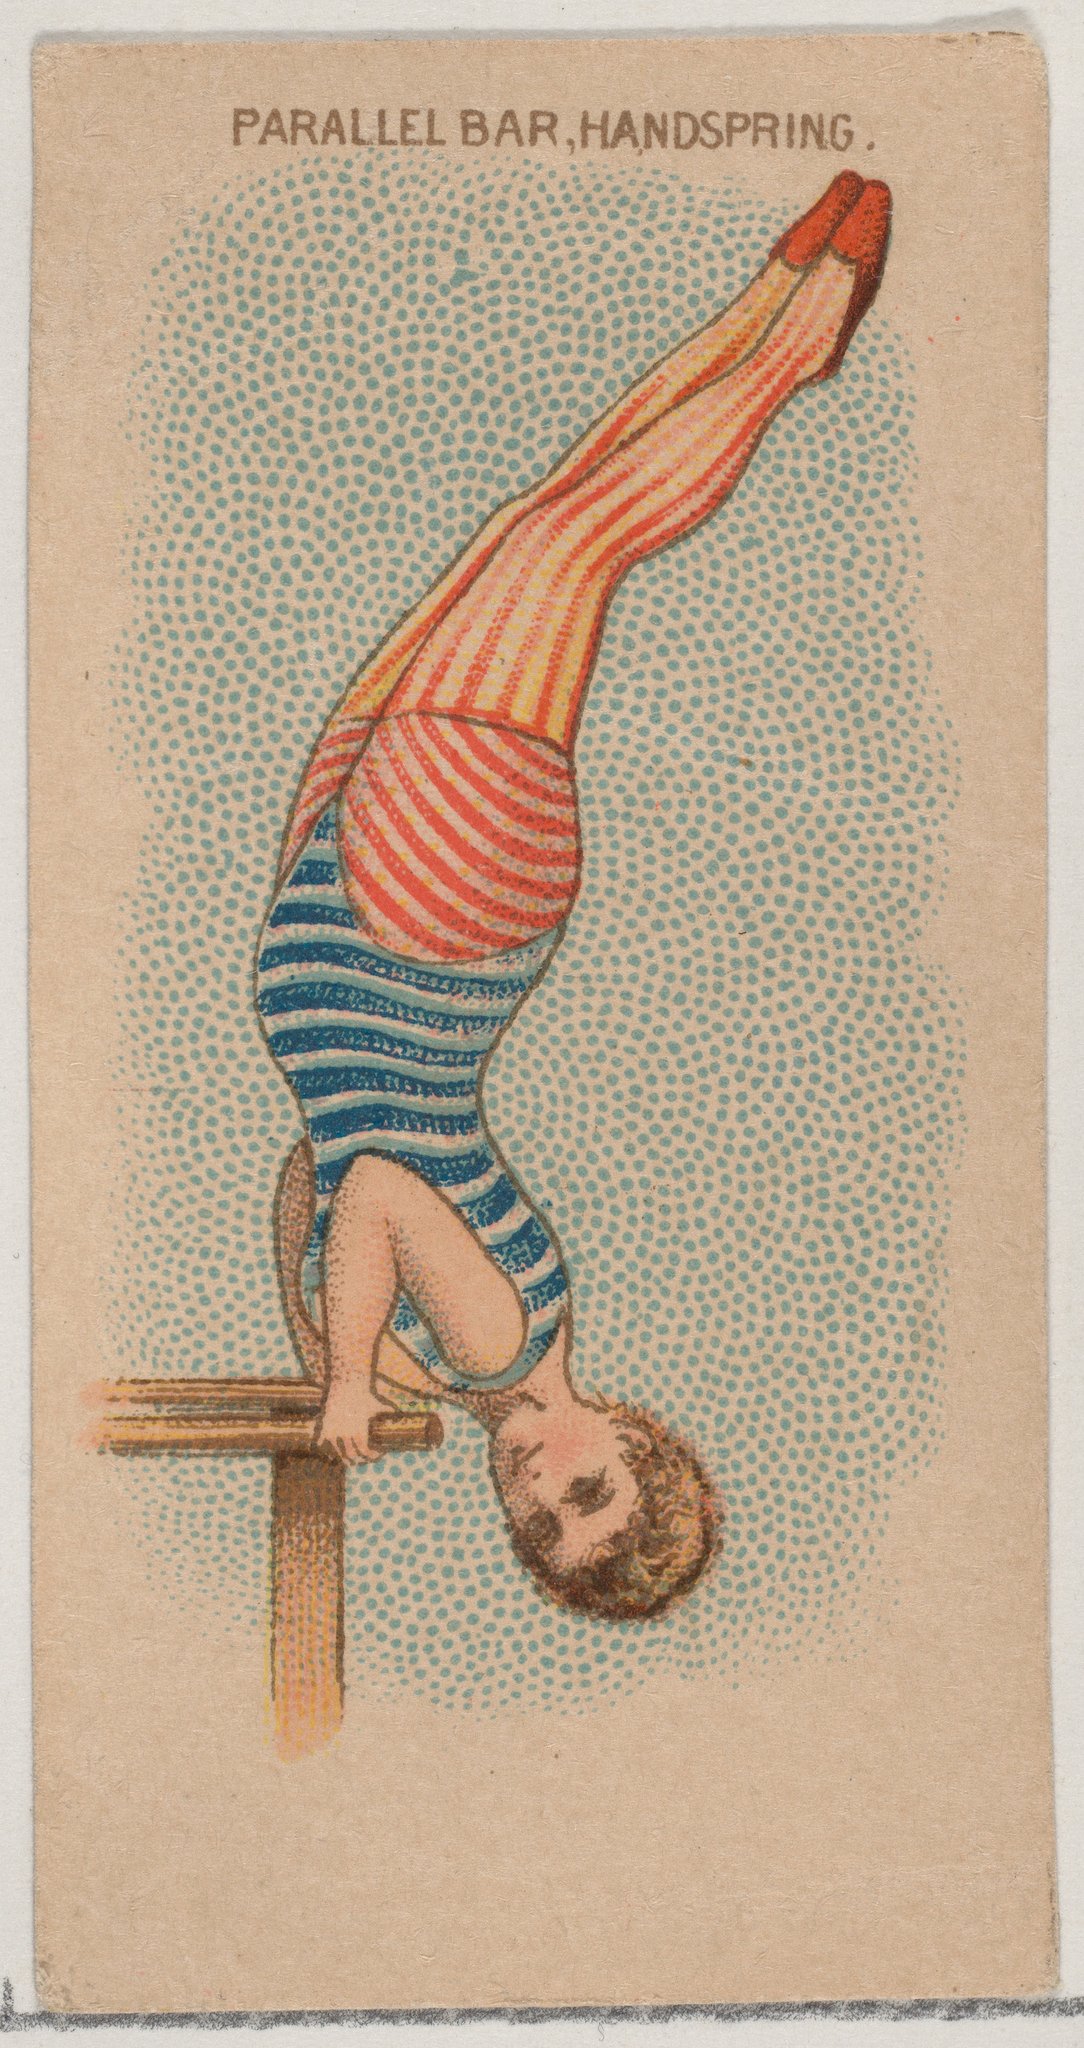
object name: print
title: Parallel Bar, Handspring, from the Gymnastic Exercises series (N77) for Duke brand cigarettes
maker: w. duke, sons & co.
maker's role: publisher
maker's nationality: american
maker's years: 1870-1920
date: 1887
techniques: color lithograph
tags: women,sports,athletes